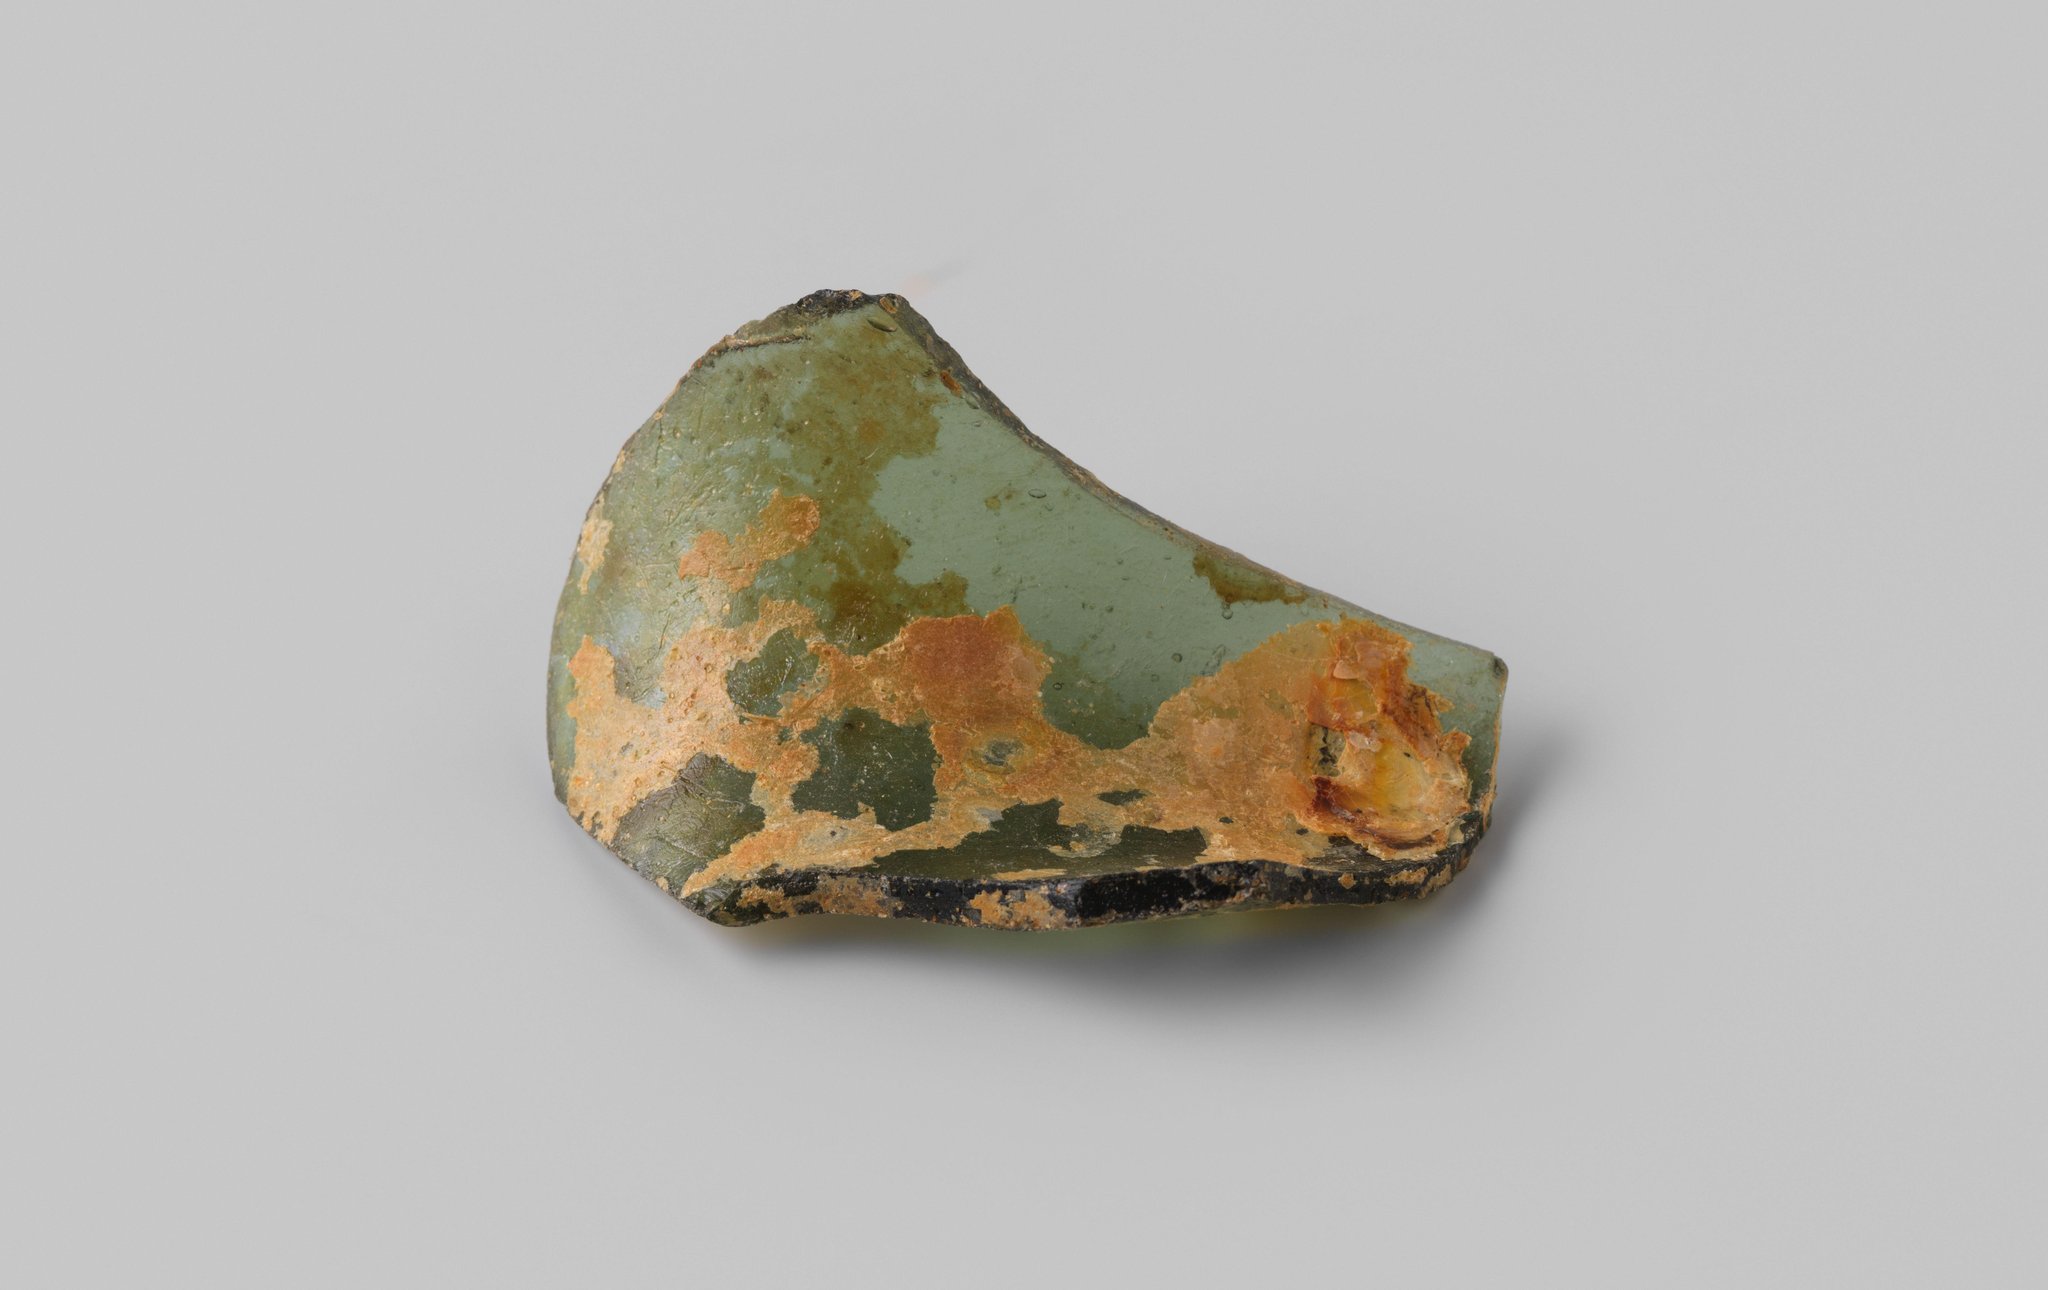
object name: wine bottle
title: Scherf van een wijnfles uit het wrak van de Oost-Indiëvaarder Hollandia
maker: Anonymous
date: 1700-1743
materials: glass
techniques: green glass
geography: netherlands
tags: verenigde oostindische compagnie, hollandia (schip)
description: Typologically not identifiable, neck, fragment.